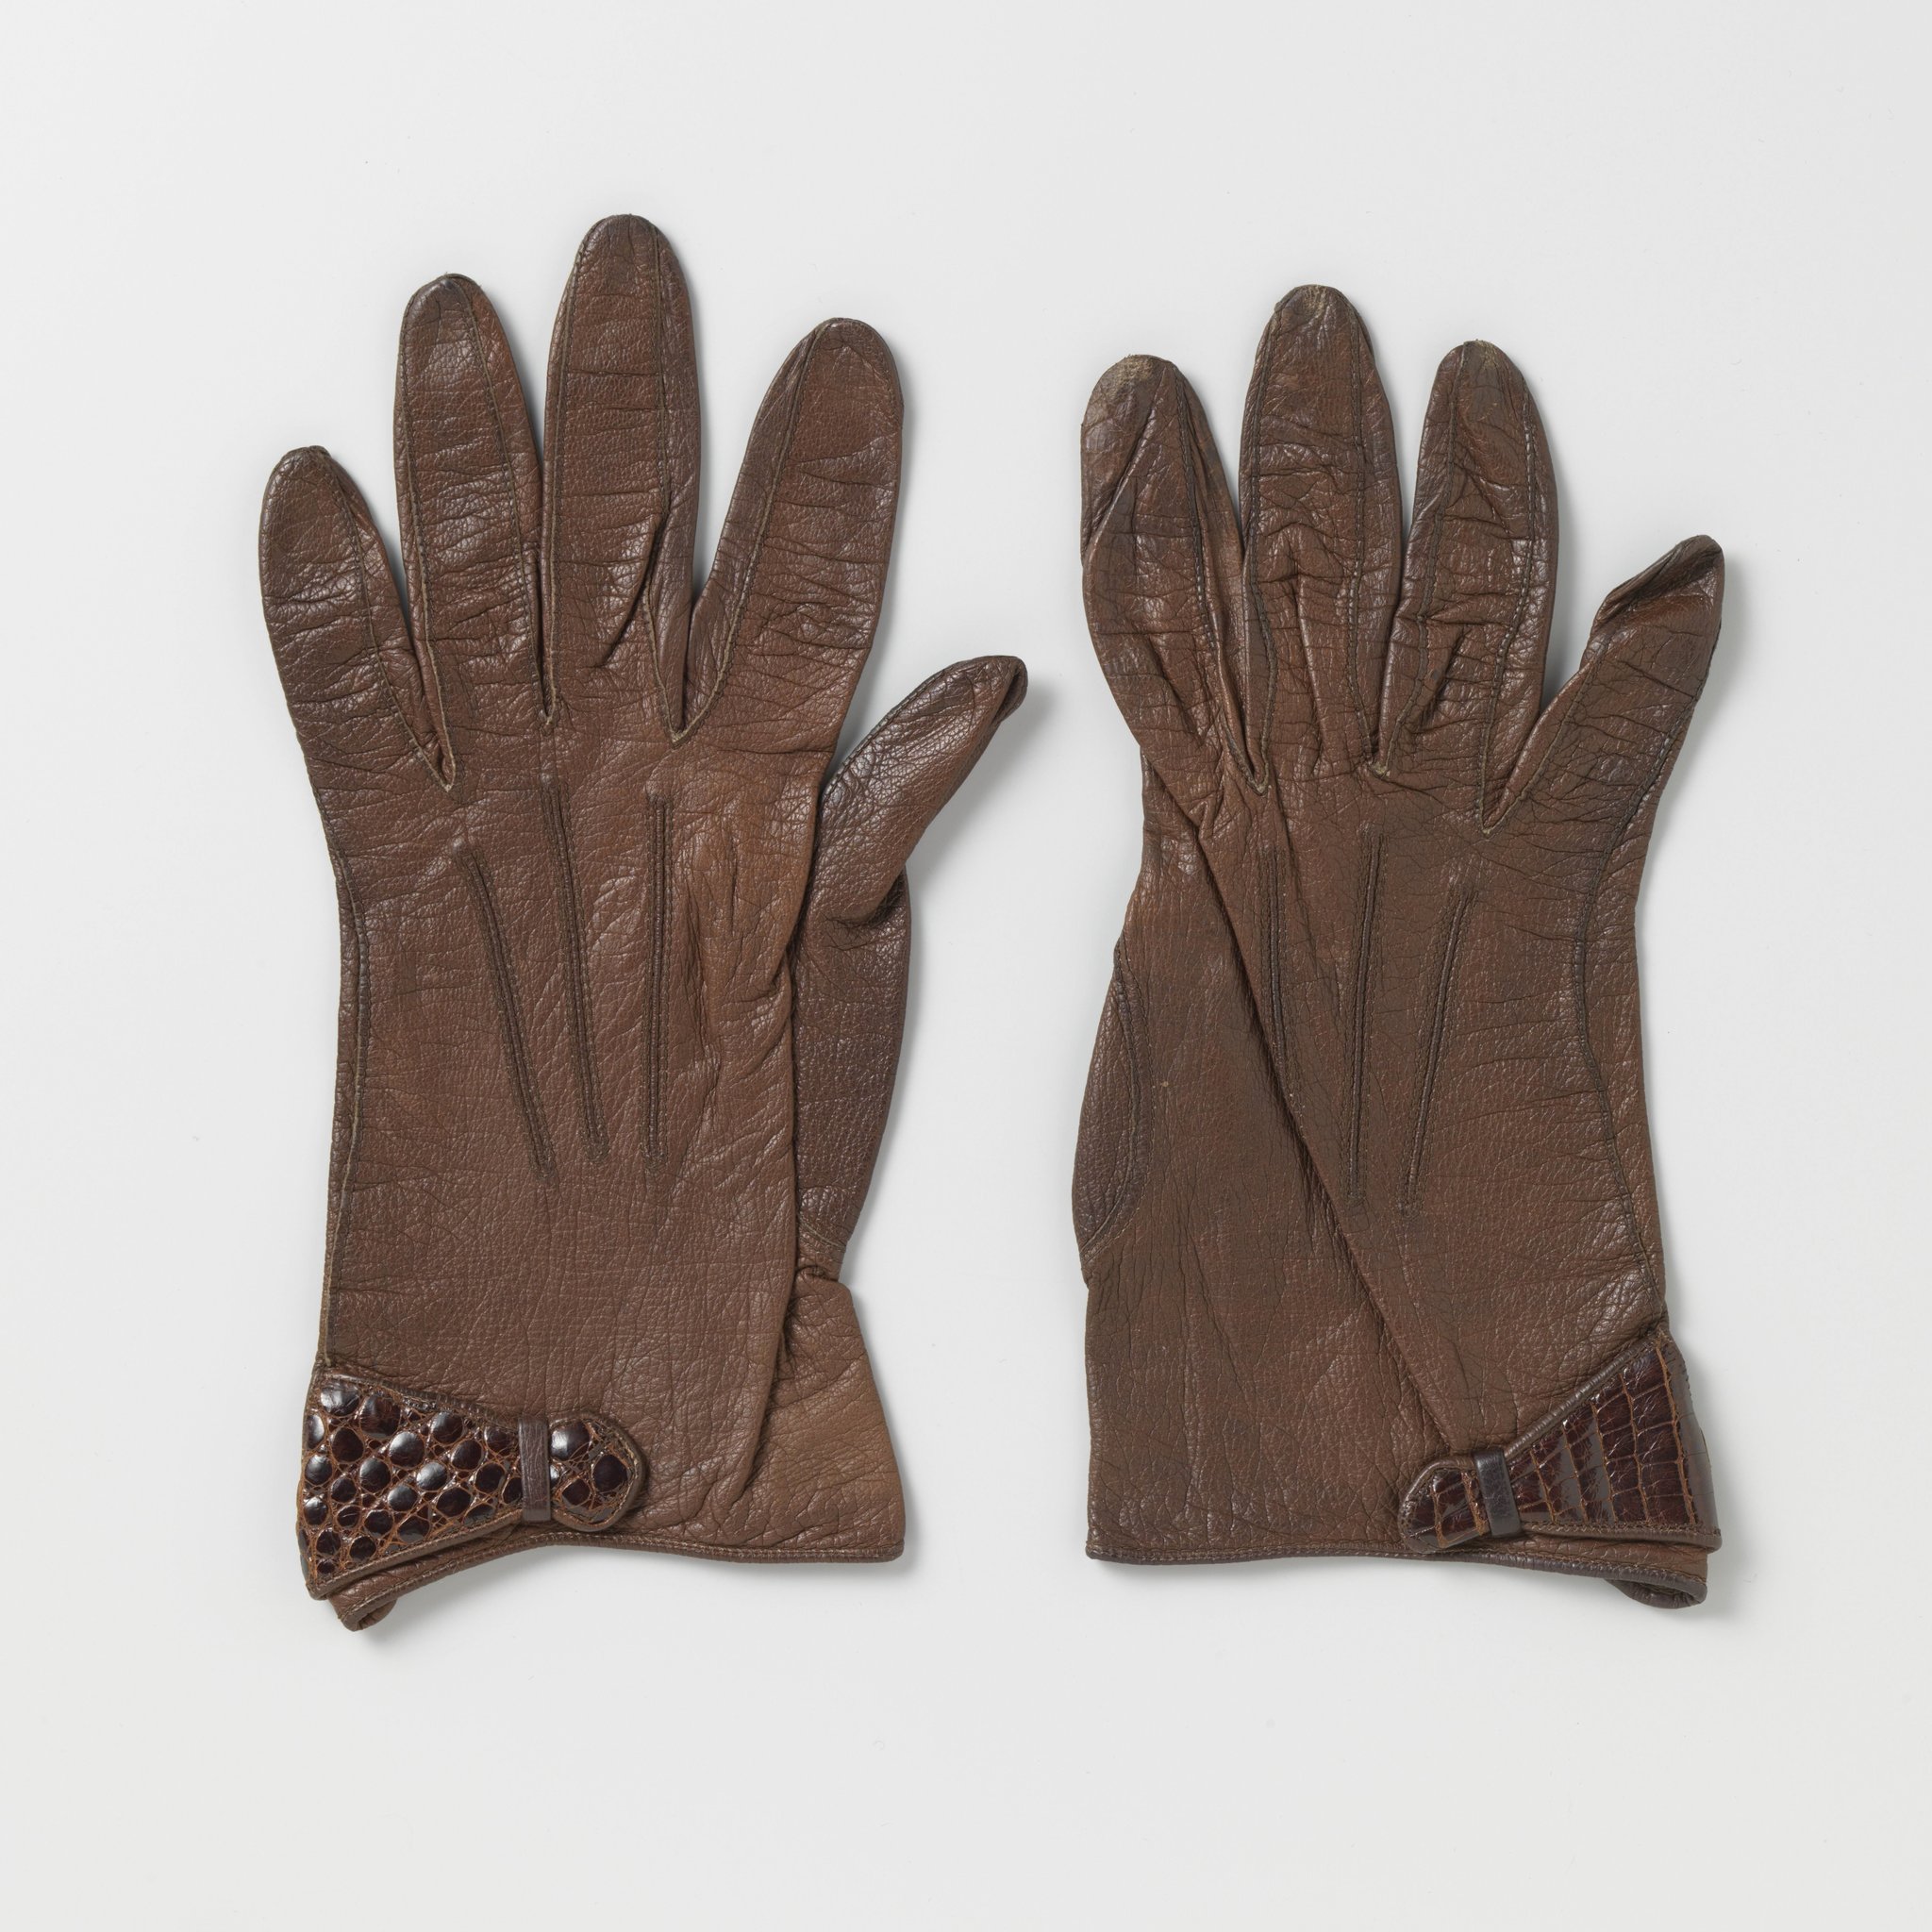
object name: glove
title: Pair of gloves with cuffs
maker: Anonymous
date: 1900-1915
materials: leather, skin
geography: netherlands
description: Linker handschoen van roodbruin leer en slangenleren omslagen bij de pols. Op de rug drie uitstralende koorden.